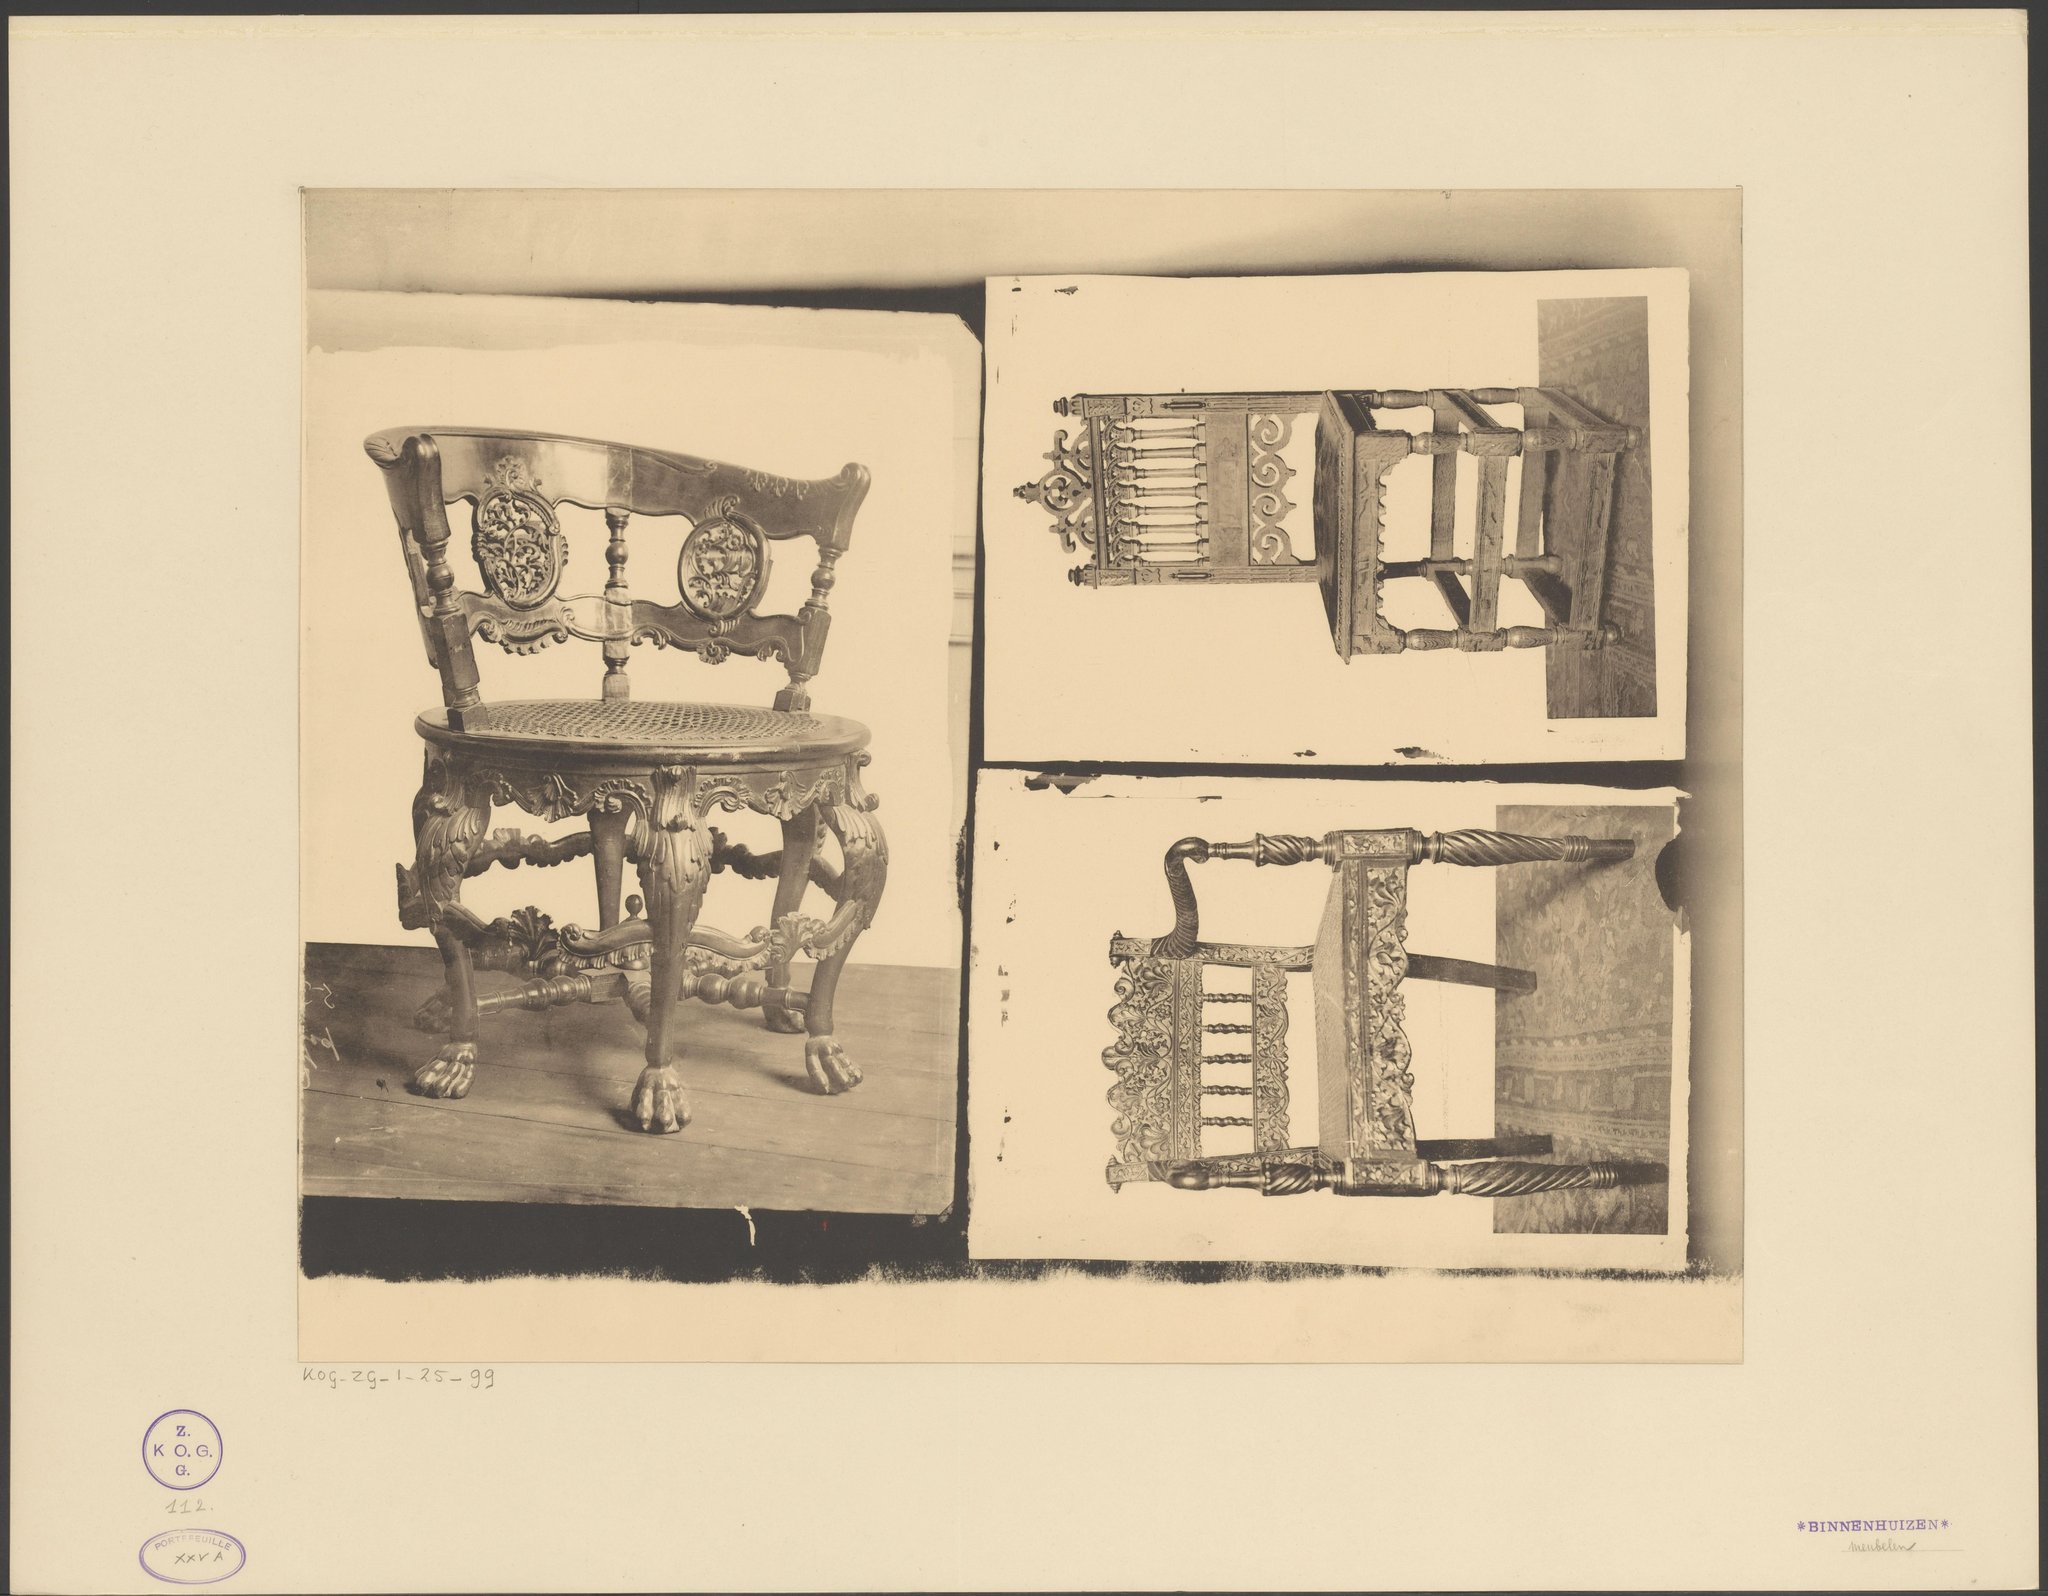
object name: photomechanical print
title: Drie stoelen uit verschillende tijden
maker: Anonymous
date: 1875-1930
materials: paper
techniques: photograph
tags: armchair, seat, chair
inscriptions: stamp, collector's mark: Lugt 1641, stamp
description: Links een stoel uit 1750 uit Indonesië. Rechtsboven een stoel uit de zeventiende eeuw. Onderwerpsrubrieken binnen de Atlas Zeden en Gewoonten: Zeden en Gewoonten in Engeren Zin, De Woning, Binnenhuizen, Meubelen.